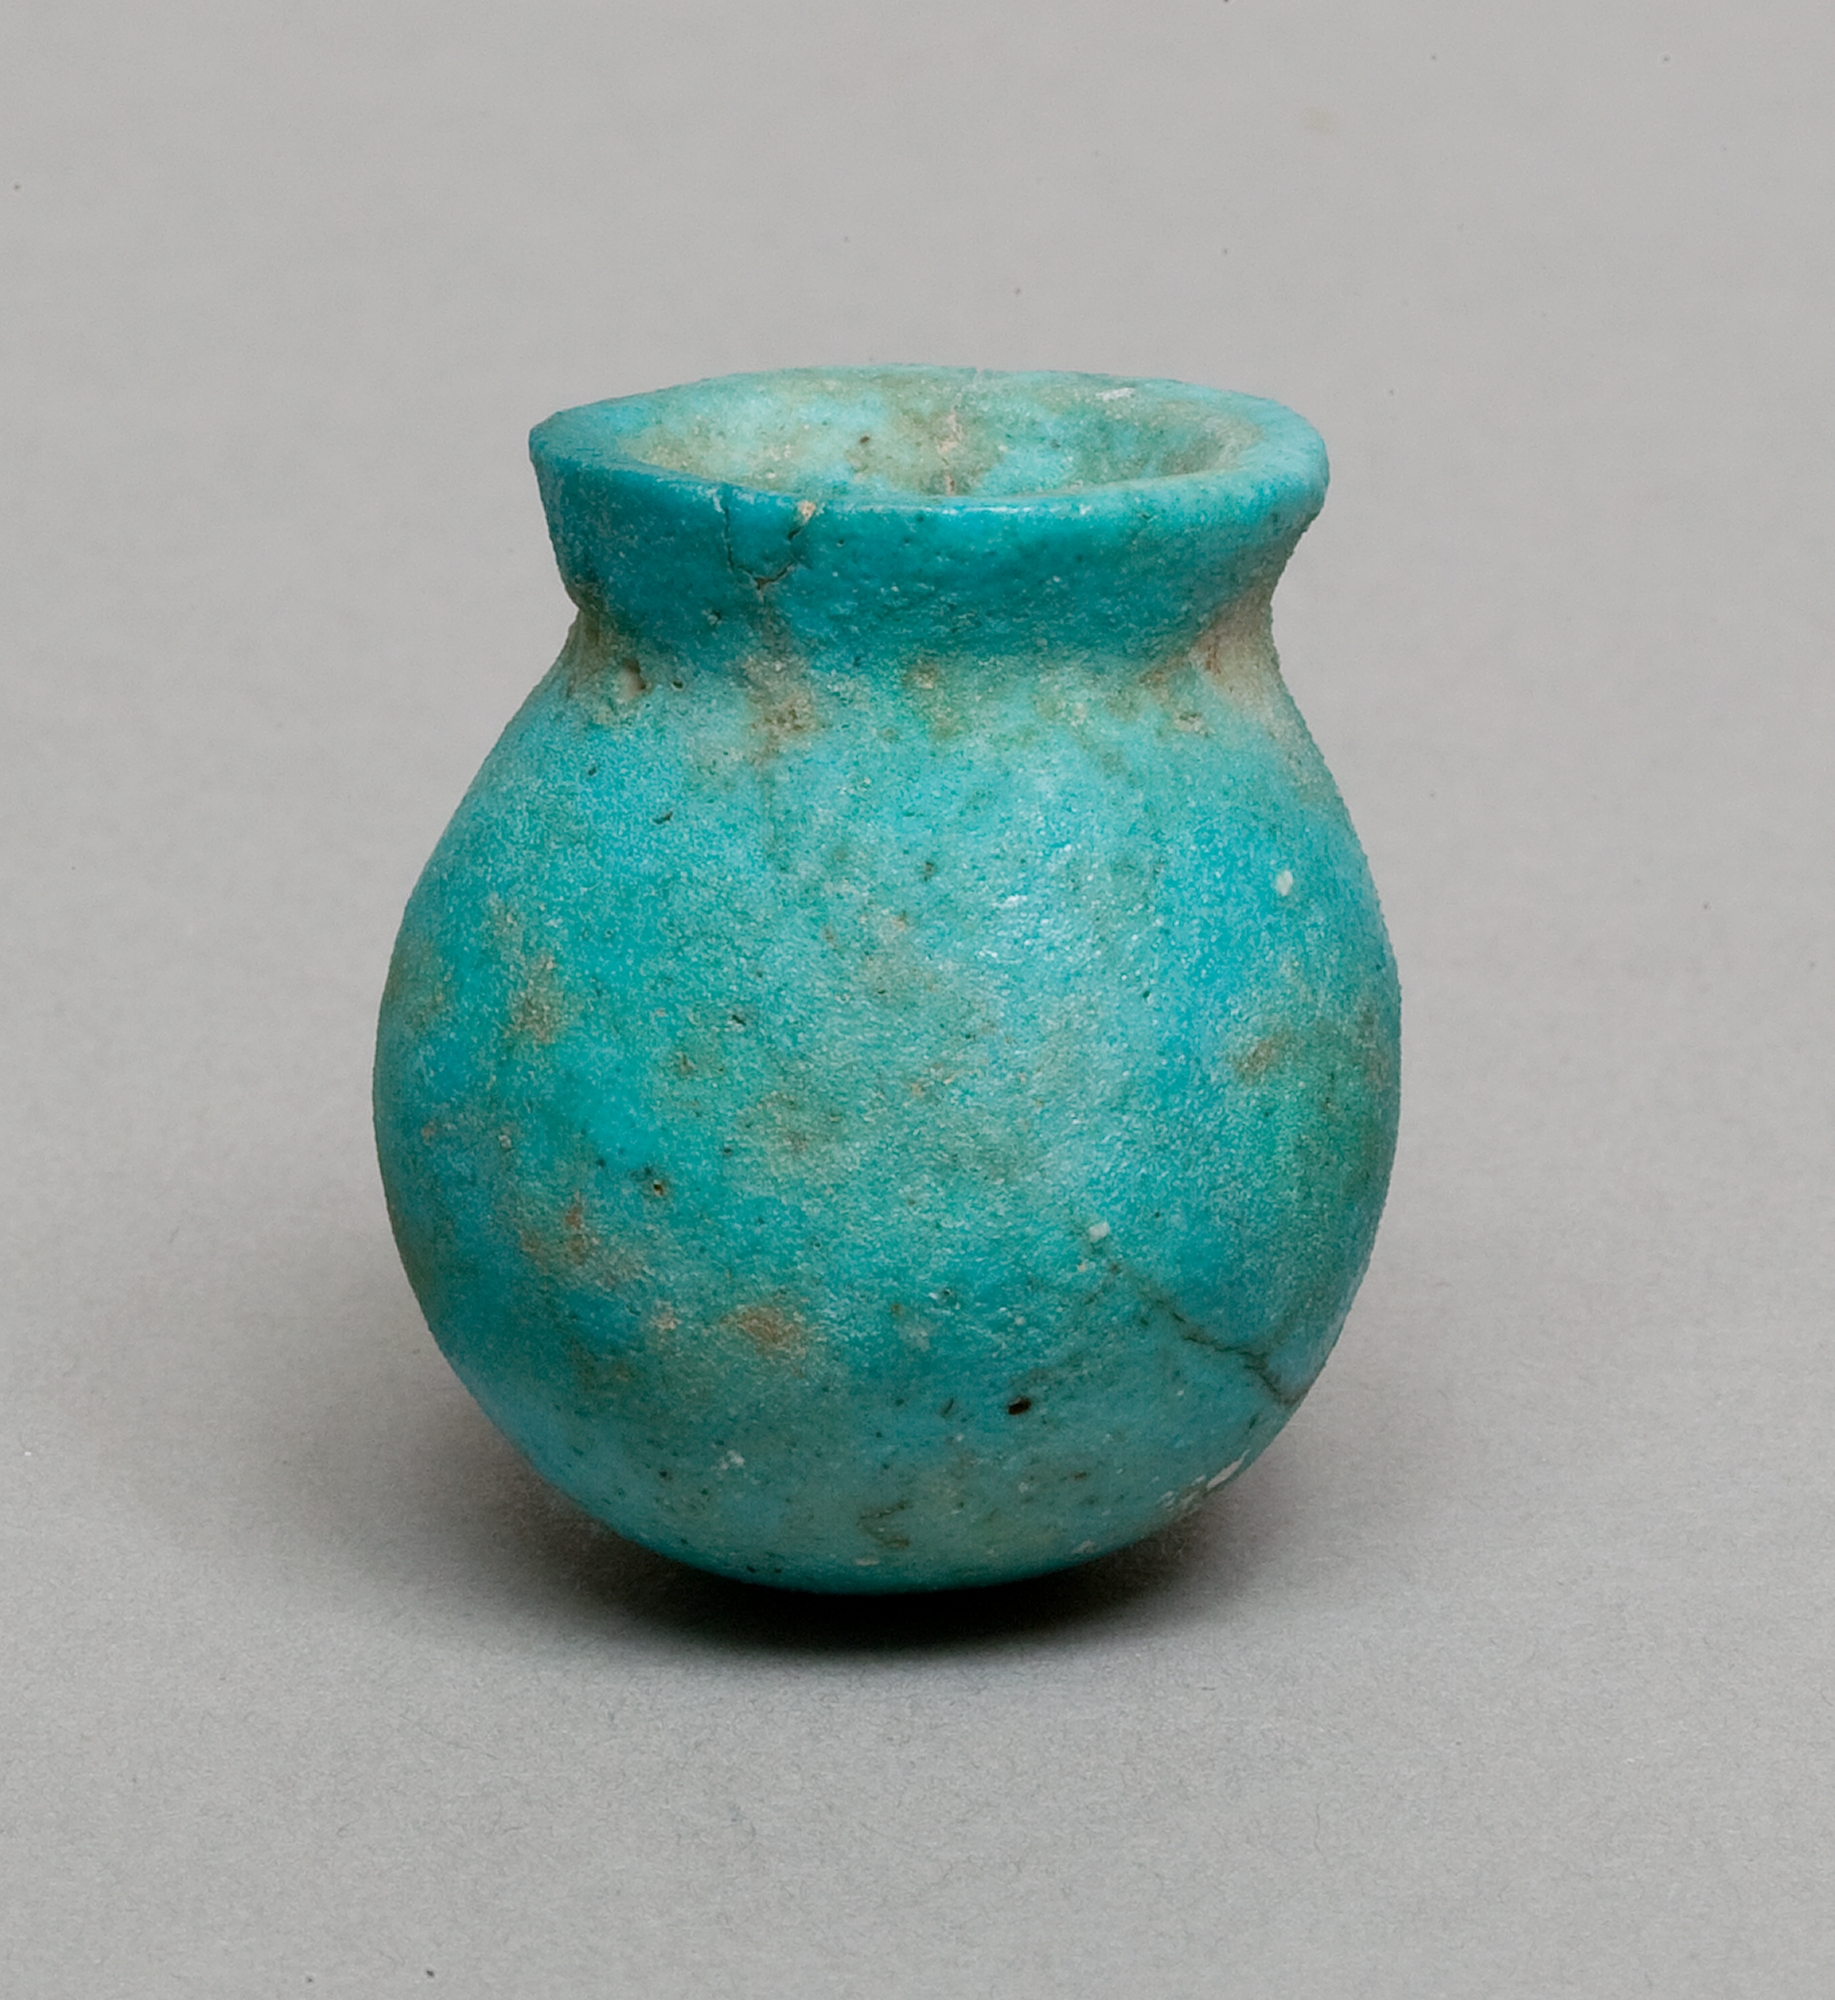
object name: toilet vase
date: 1850-1775 BCE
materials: faience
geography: egypt